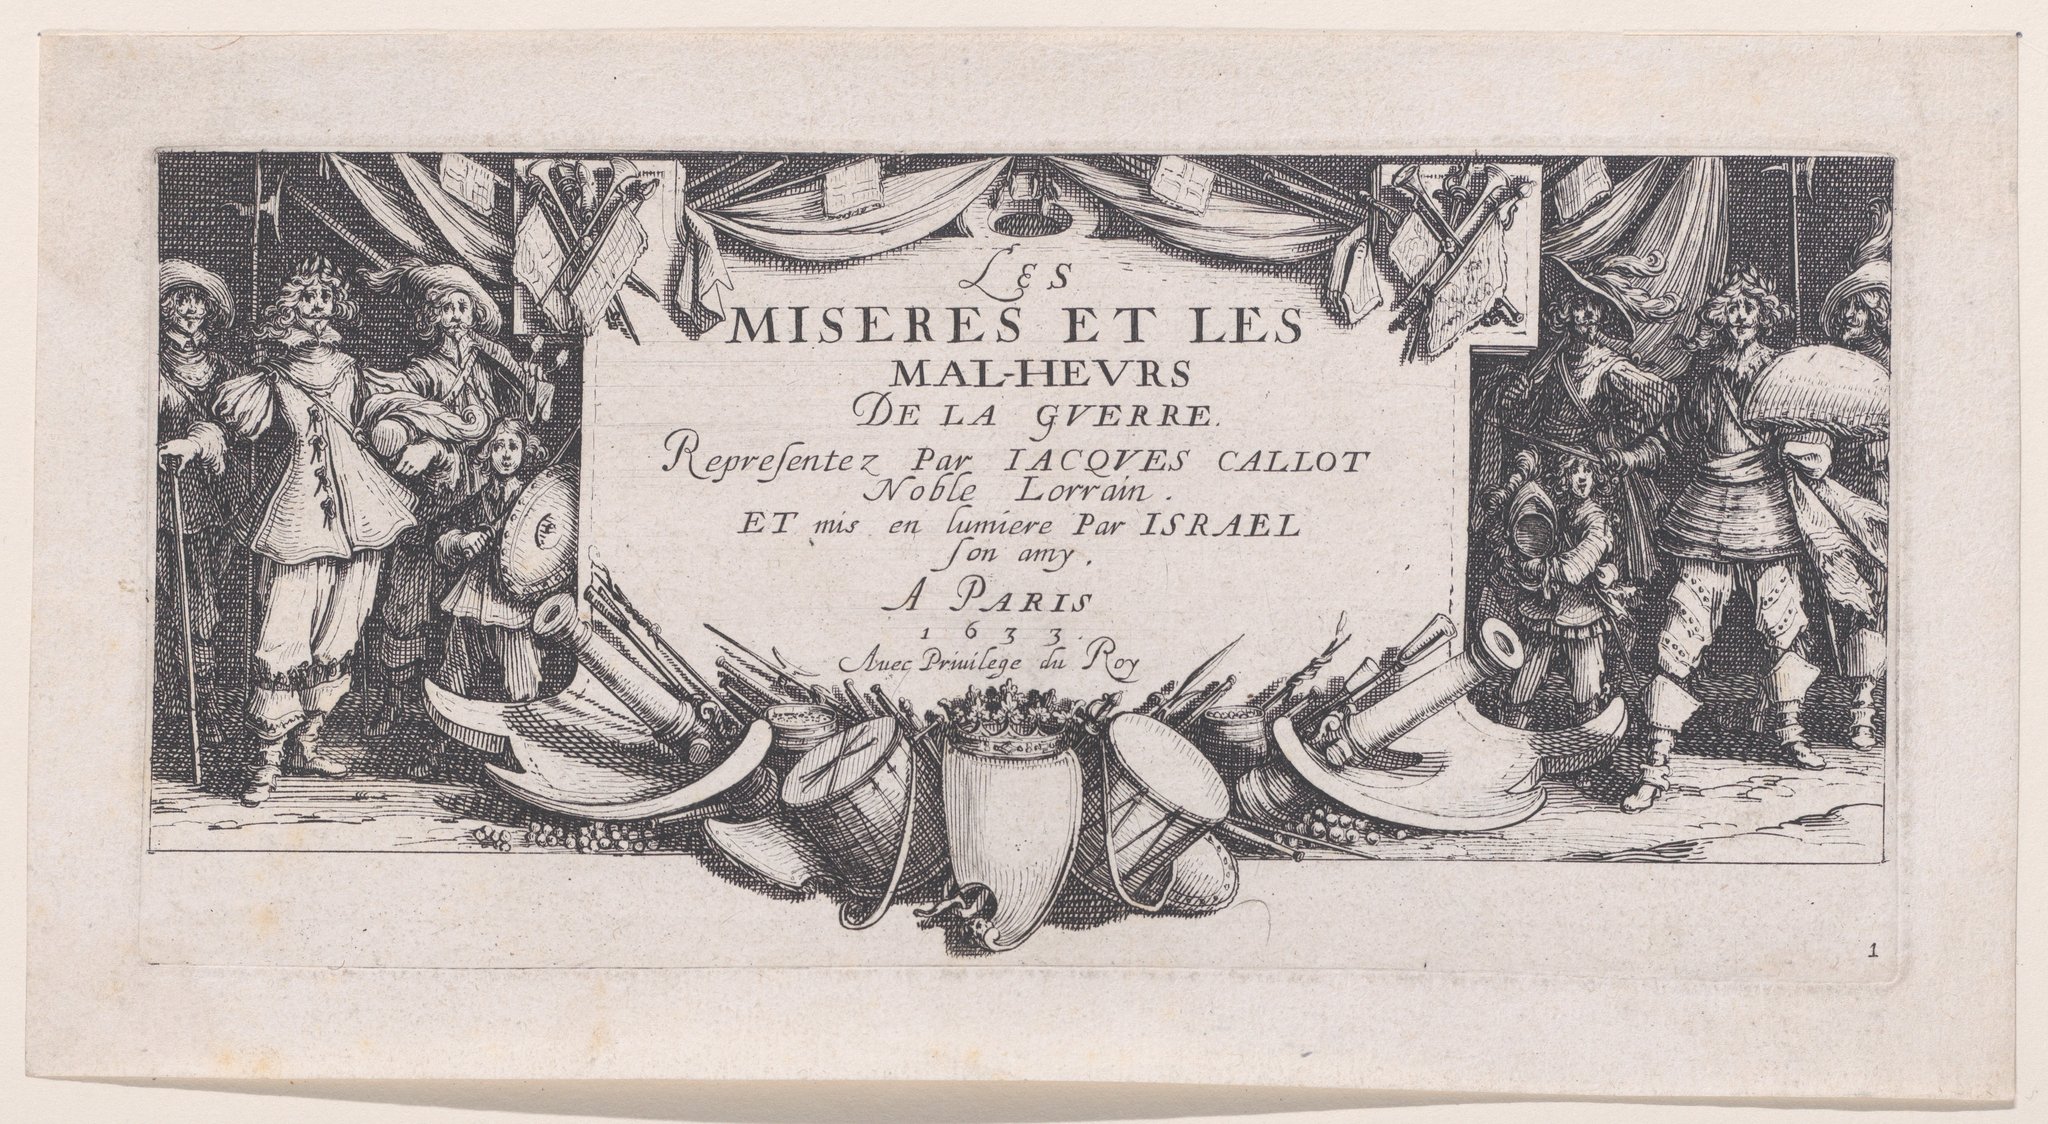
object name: print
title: Frontispiece, from Les Misères et les Mal-Heures de la Guerre (The Miseries and Misfortunes of War), plate 1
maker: jacques callot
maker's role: artist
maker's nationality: french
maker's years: 1592-1635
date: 1633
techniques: etching